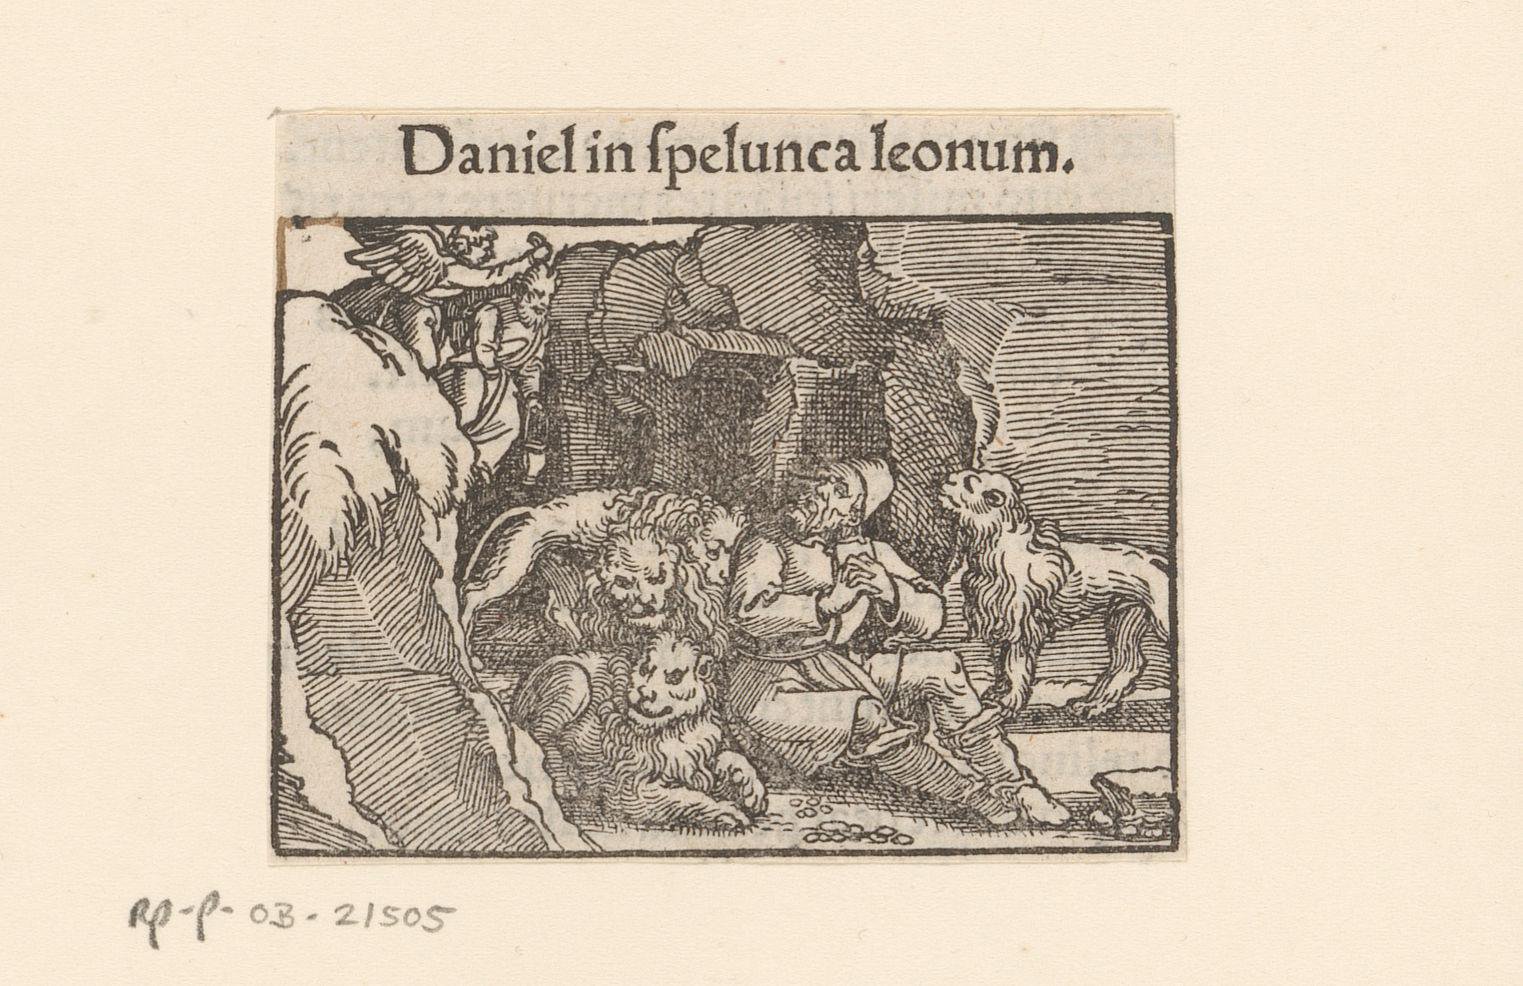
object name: print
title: Daniel in spelunca leonum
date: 1530-1533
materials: paper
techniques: woodcut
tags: daniel sitting unharmed in the lion's den, surrounded by lions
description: Prent afkomstig uit: Biblicae historiae. Frankfurt am Main: Egenloph, 1539.